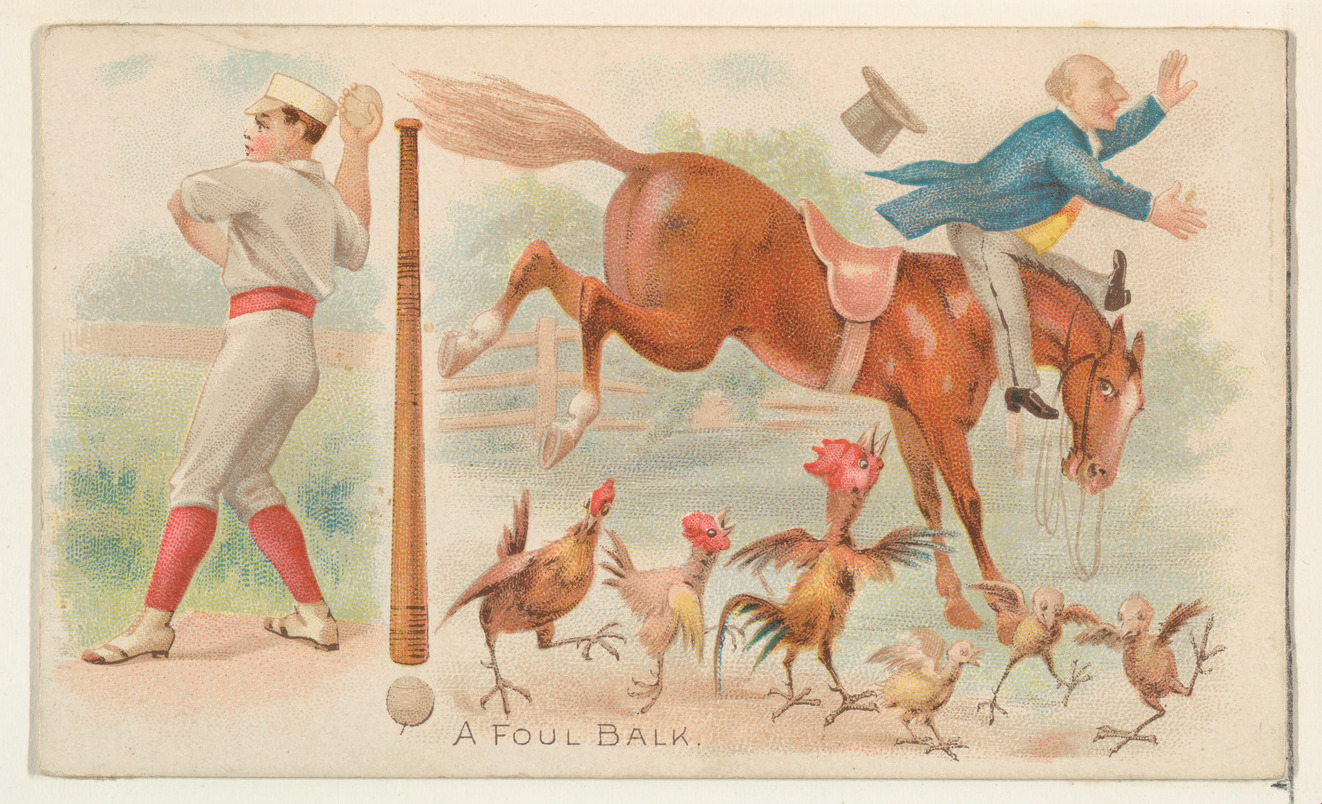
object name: print, baseball card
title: A Foul Ball, from the Talk of the Diamond set (N135) issued by Duke Sons & Co., a branch of the American Tobacco Company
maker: w. duke, sons & co.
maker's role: publisher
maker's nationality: american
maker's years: 1870-1920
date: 1888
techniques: color lithograph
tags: chickens,men,baseball,horses